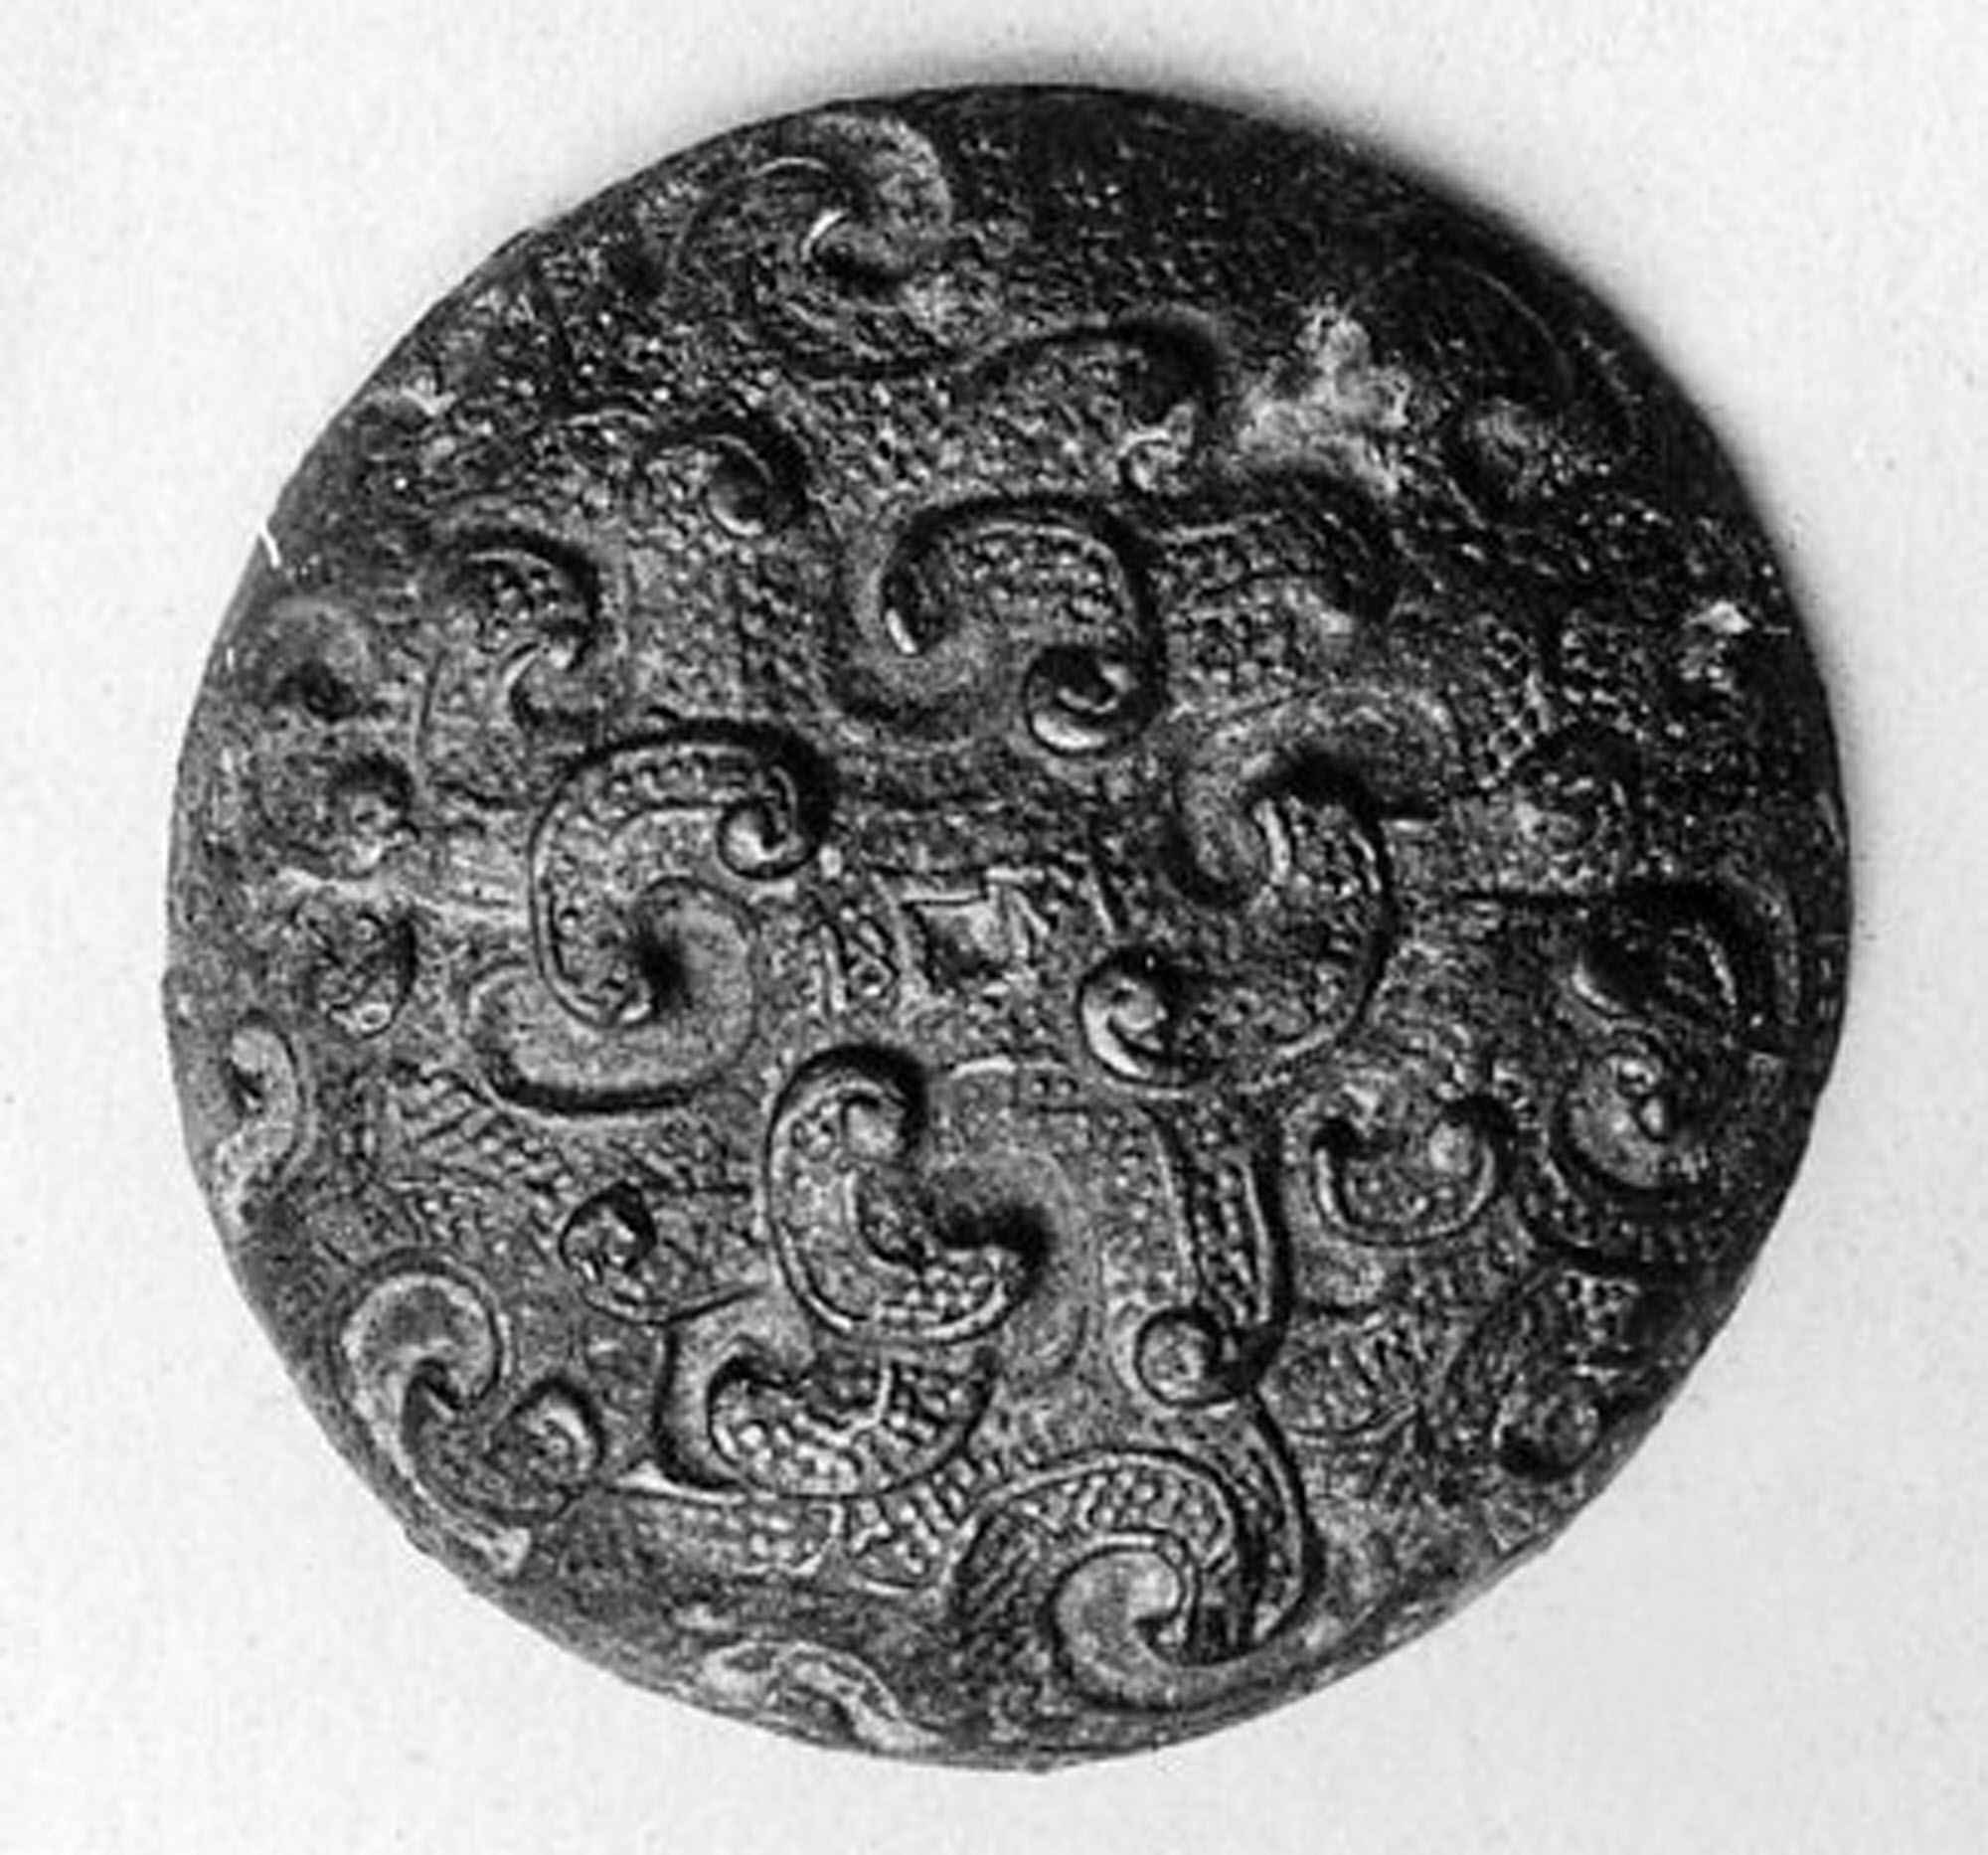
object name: button or fitting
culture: chinese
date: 221-206 BCE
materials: bronze